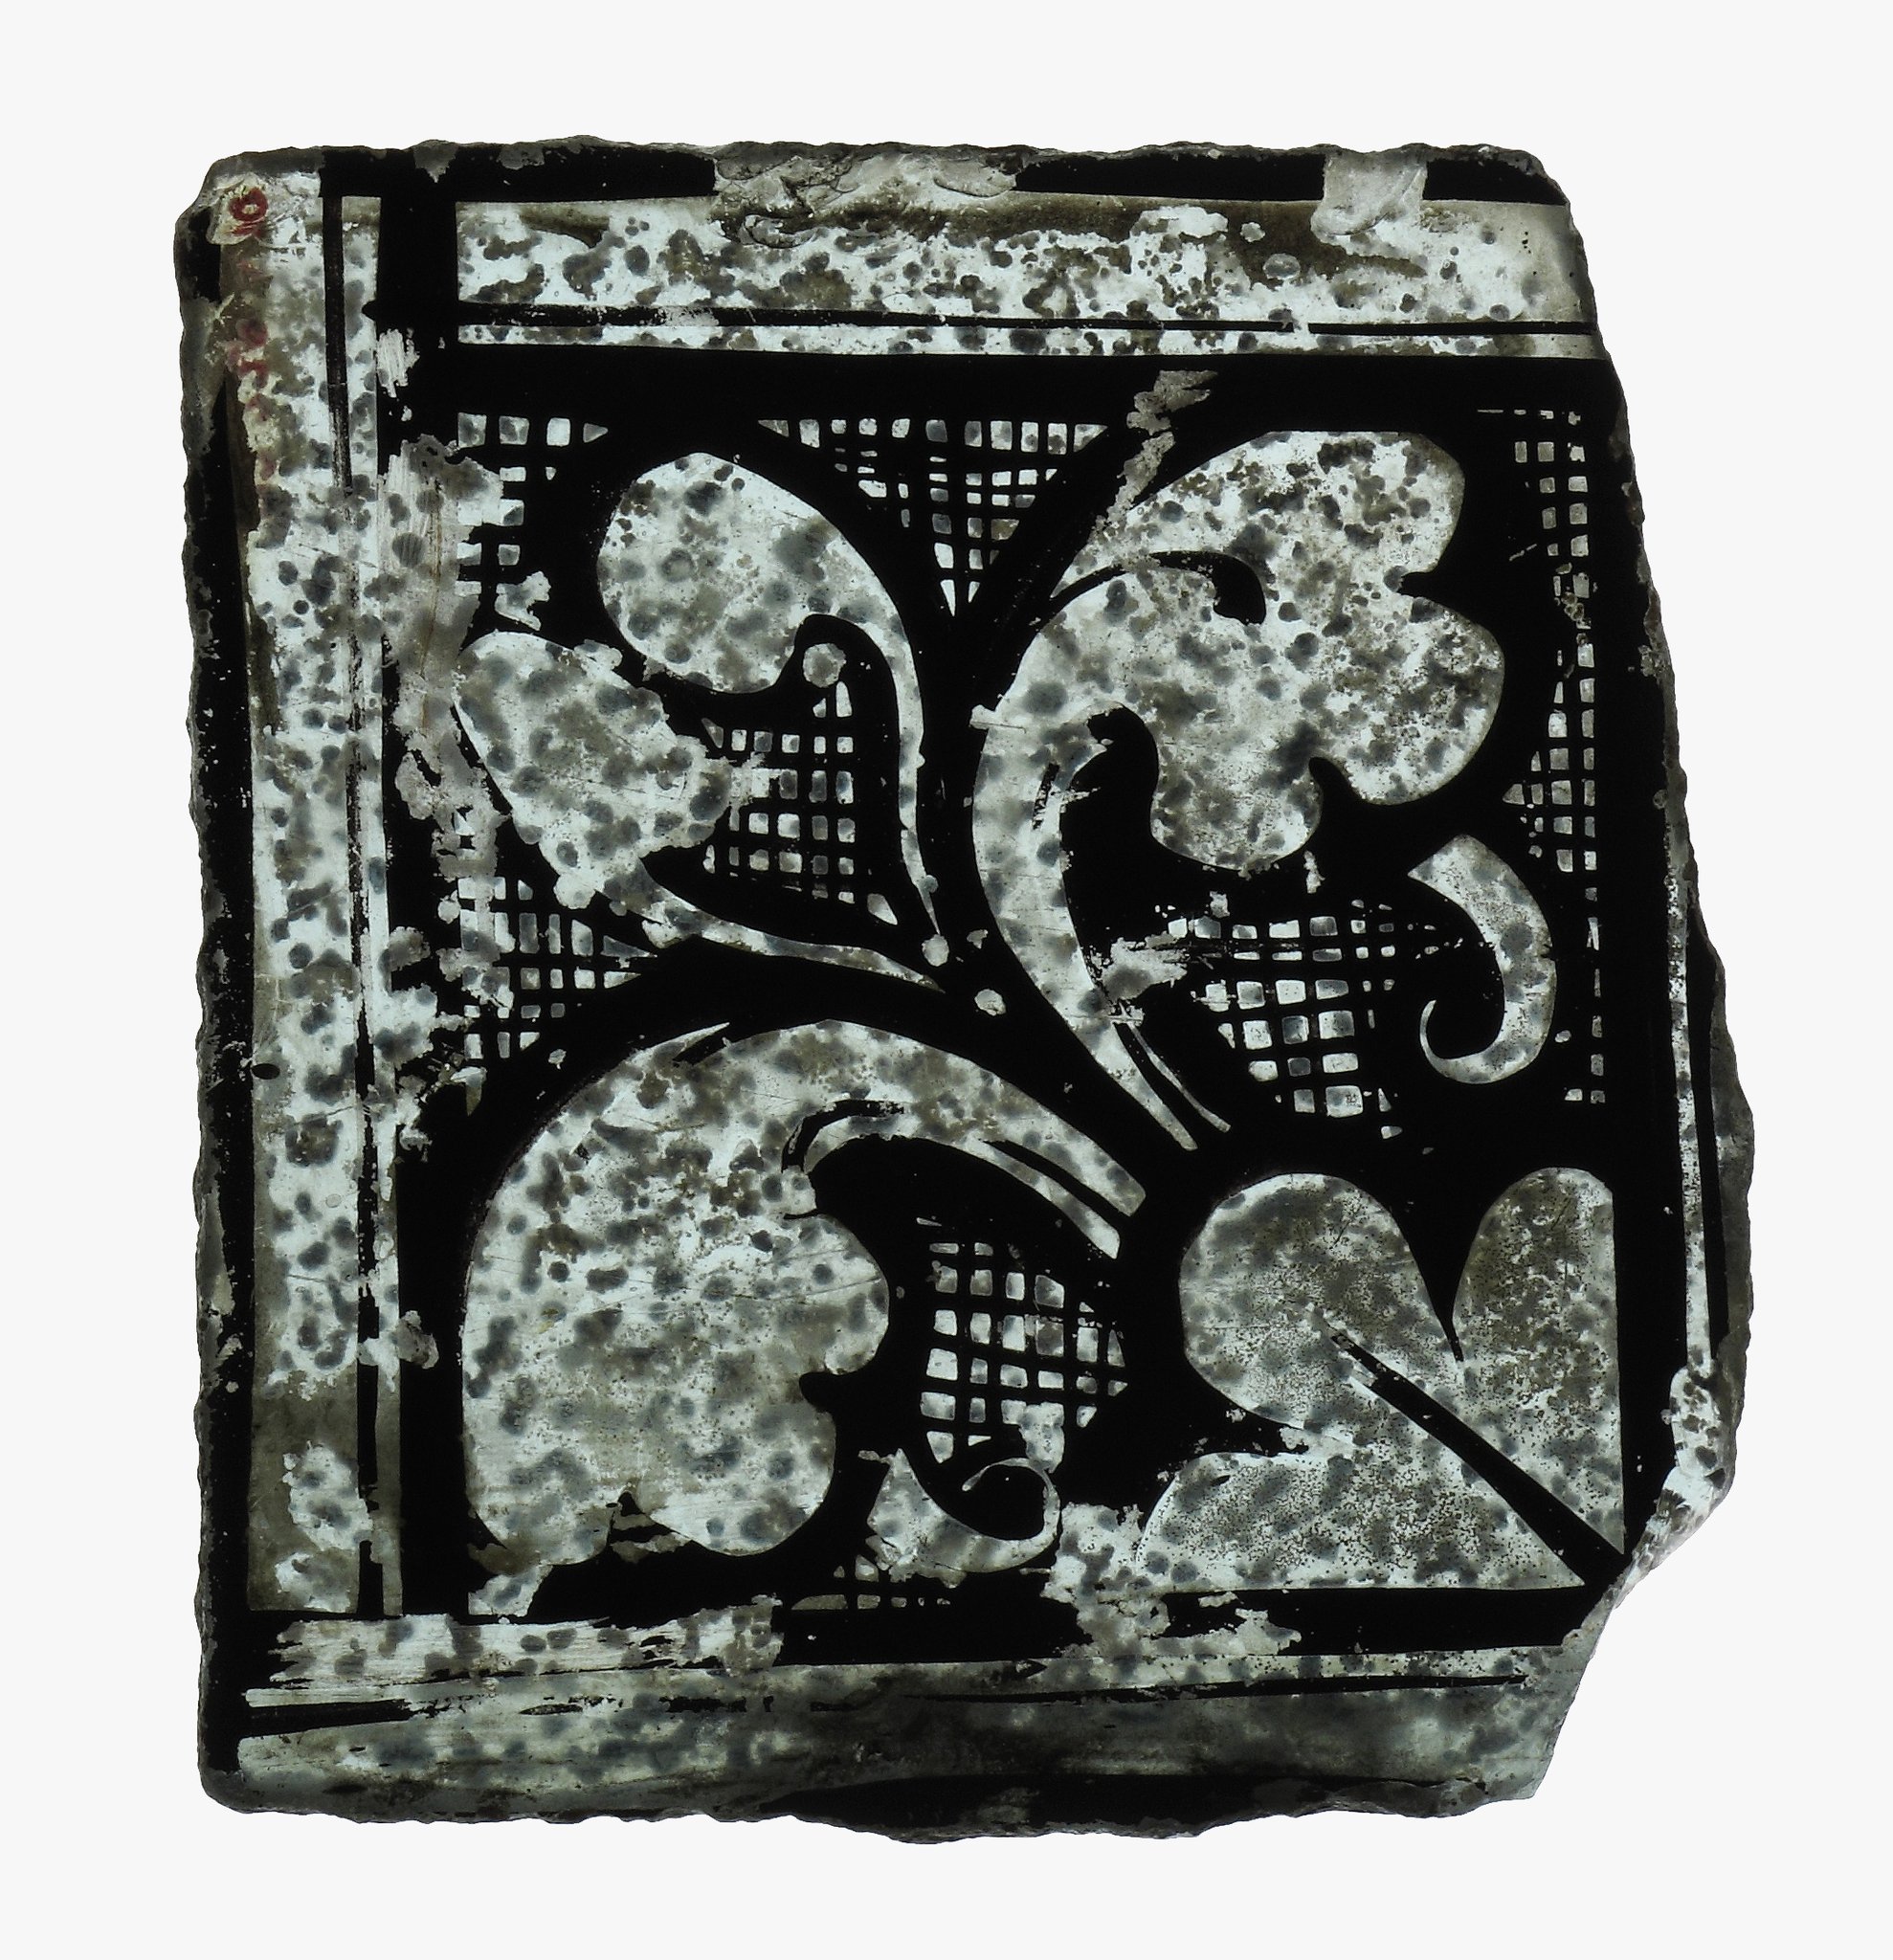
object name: fragment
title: Glass Fragment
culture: french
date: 1201-1300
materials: glass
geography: france